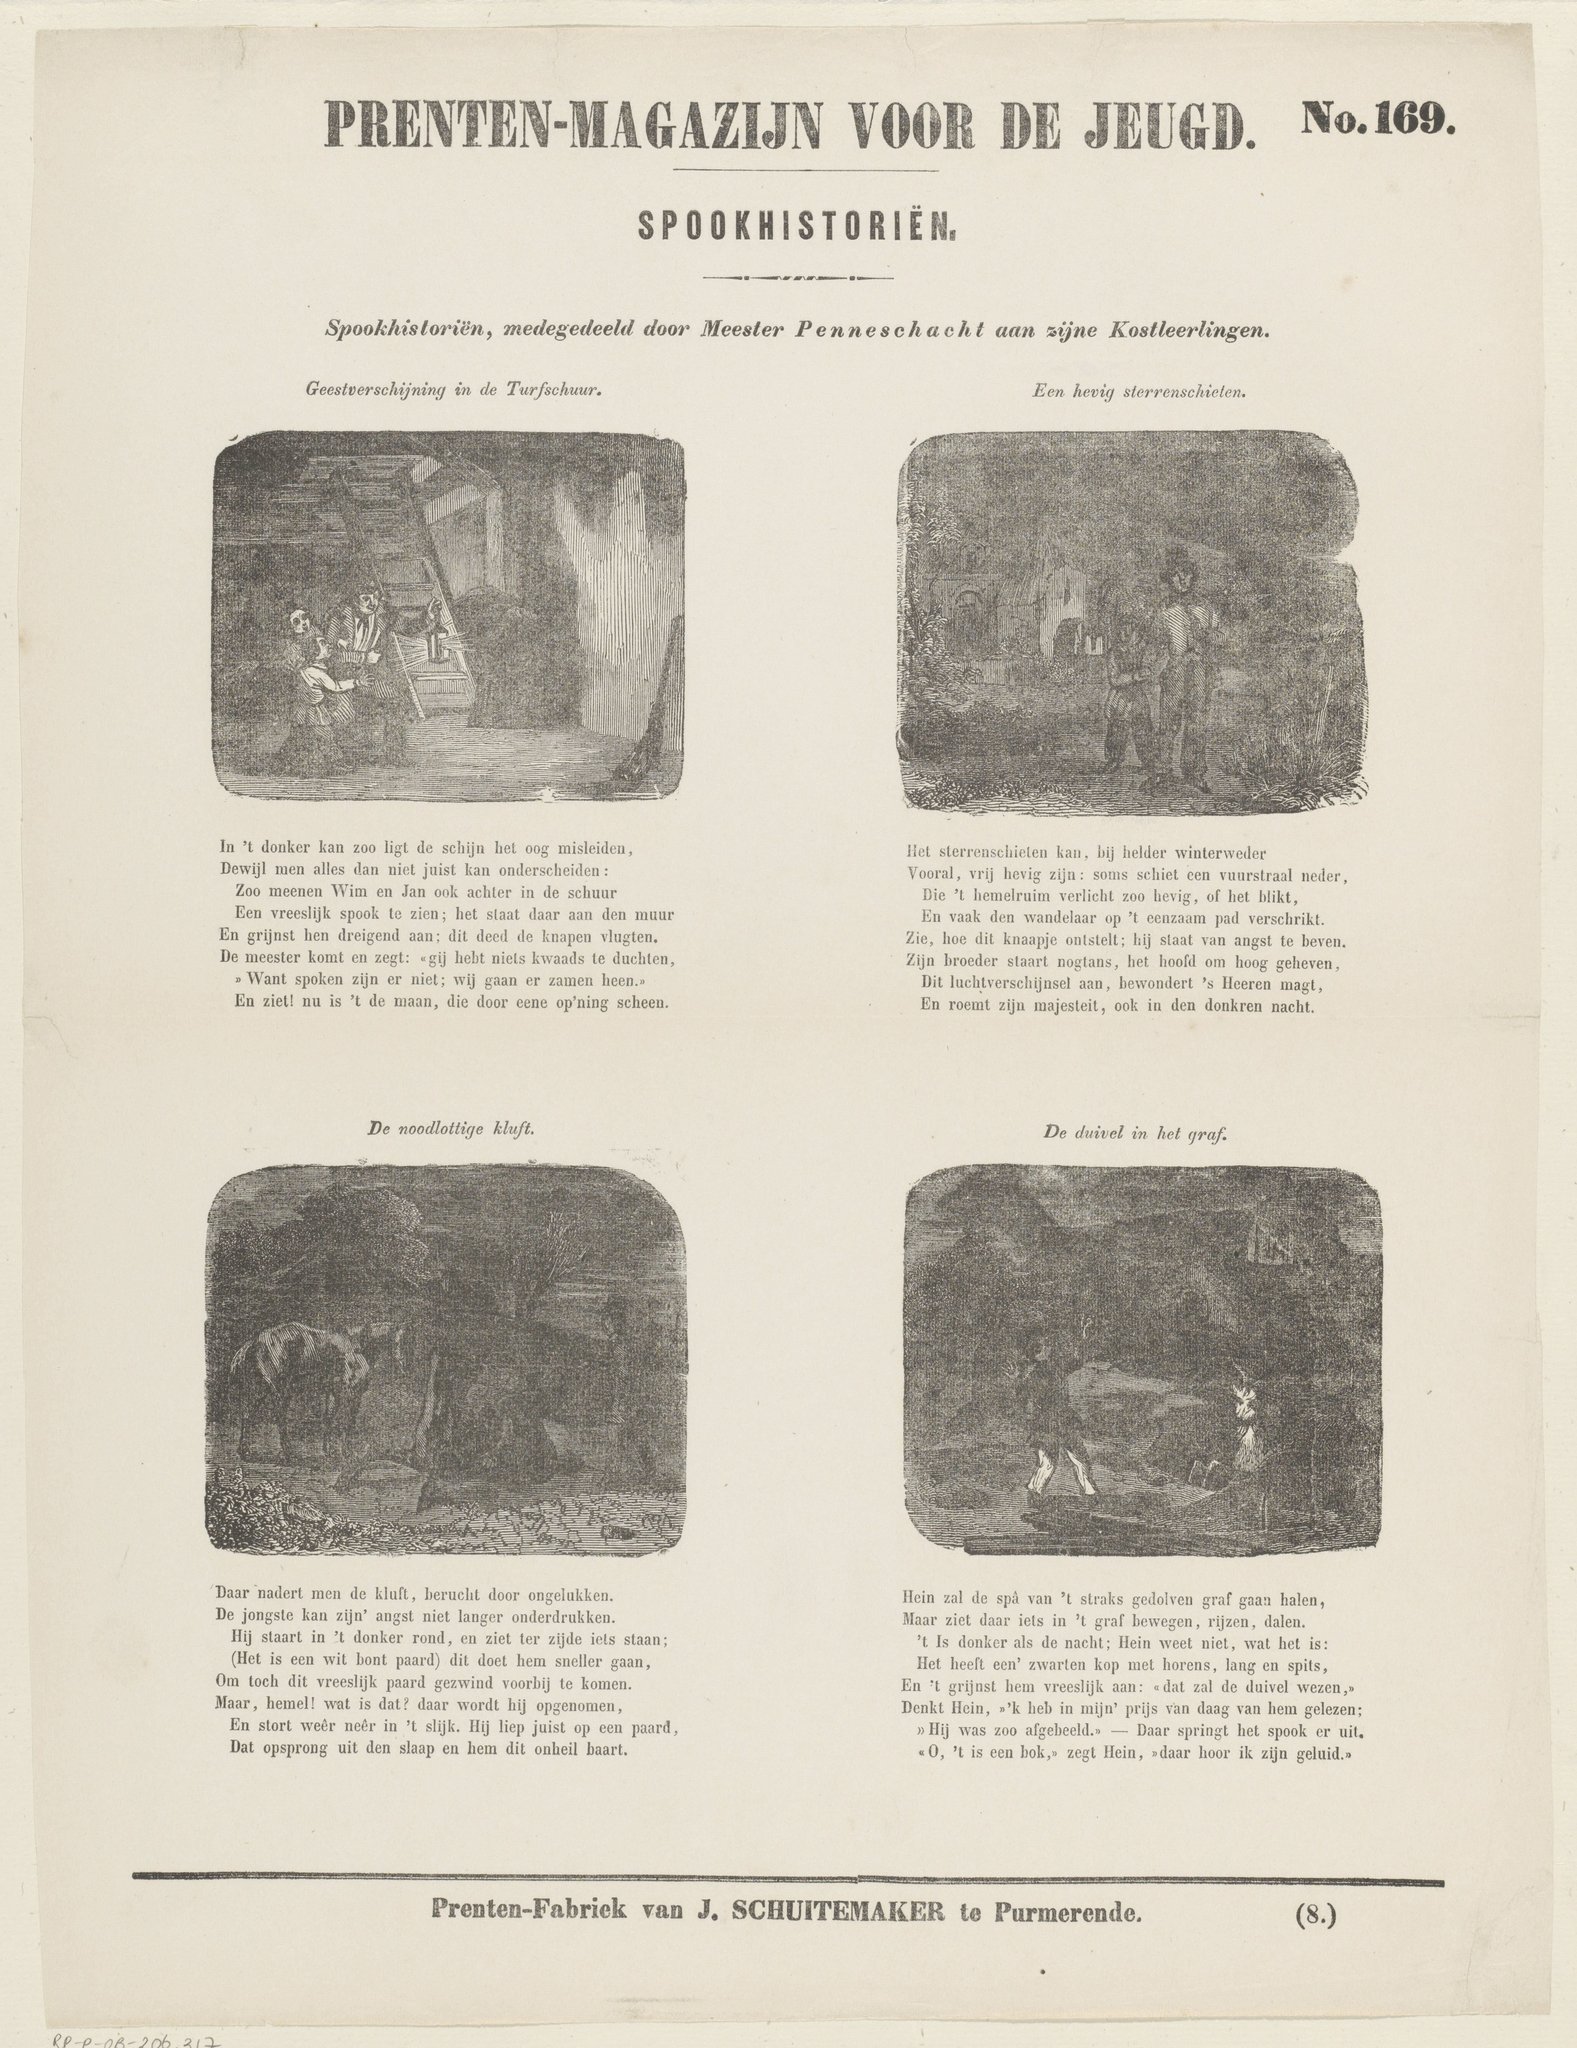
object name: print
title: Spookhistoriën, medegedeeld door Meester Penneschacht aan zijne kostleerlingen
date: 1850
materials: paper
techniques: letterpress printing, engraving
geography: netherlands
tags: tales and fairy tales, spirit, ghost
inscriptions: collector's mark: Lugt 2760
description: Na voltooiing van de acht jaargangen van de reeks 'Prenten-magazijn voor de jeugd' in 1850 heeft Jan Schuitemaker al deze prenten heruitgegeven en omgenummerd als nr. 1 t/m 192. De oorspronkelijke jaargang wordt telkens nog vermeld rechtsonder op de prent. Binnen de jaargangen zijn prenten van hetzelfde thema in clusters van vier achter elkaar gezet.